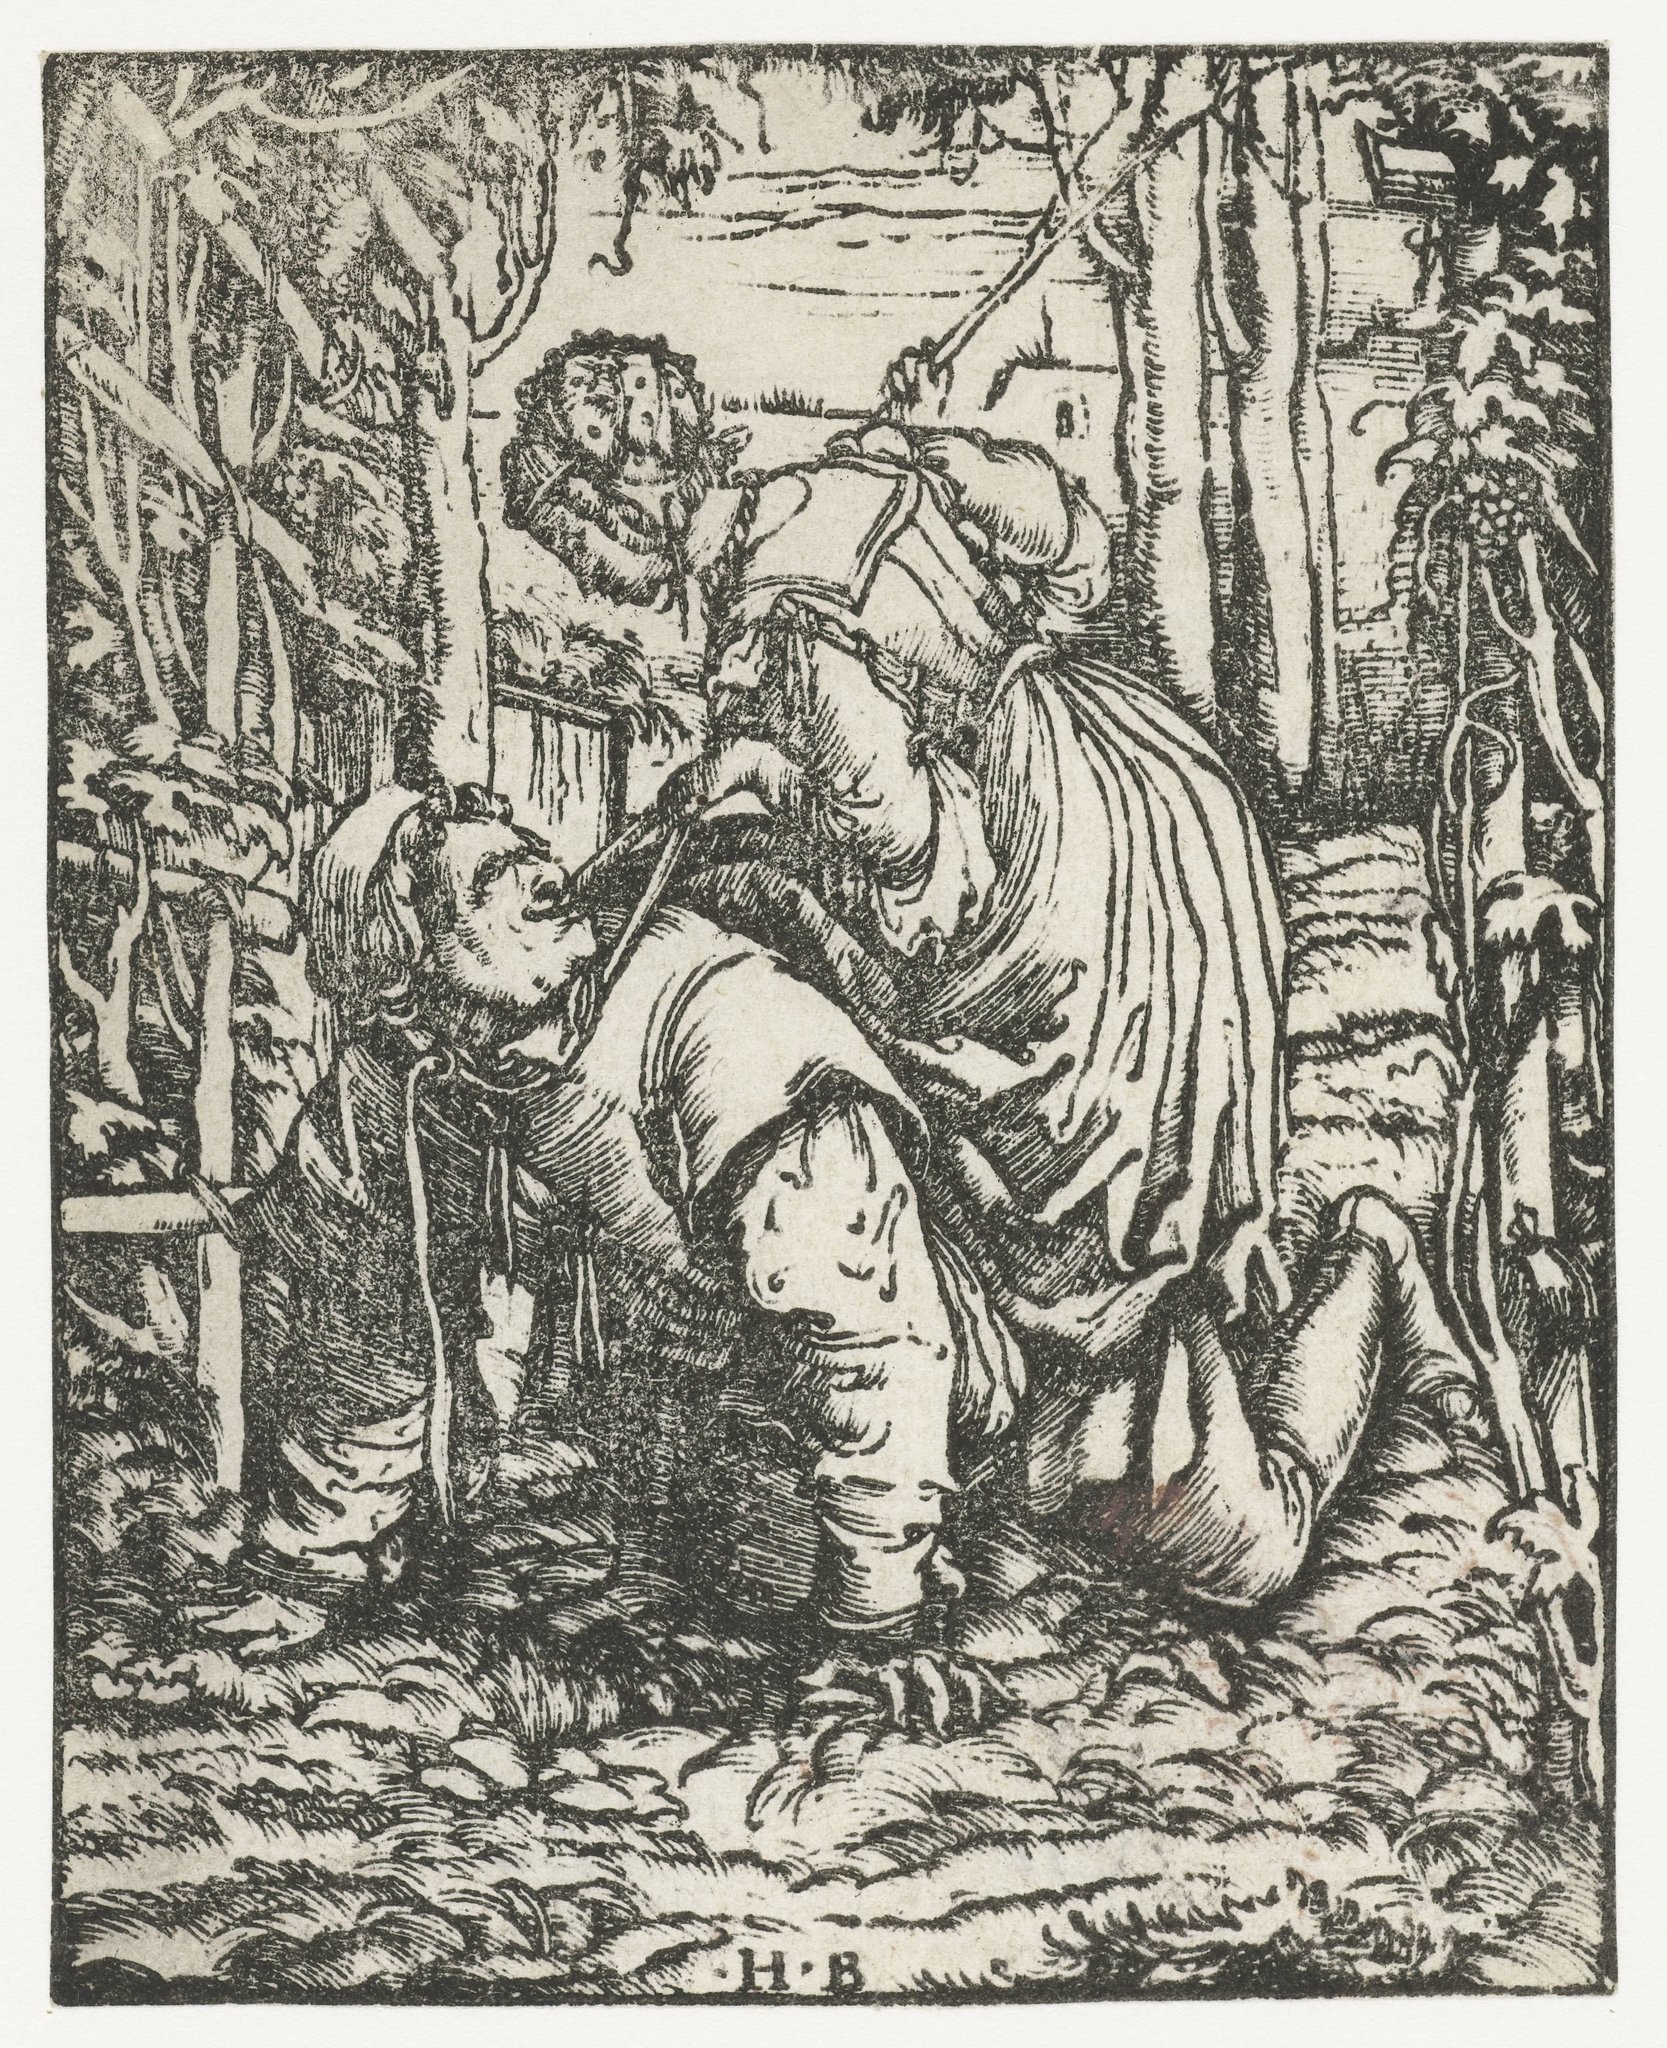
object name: print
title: Aristoteles en Phyllis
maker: hans burgkmair (i)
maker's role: draughtsman, print maker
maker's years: 1473-1531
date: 1483-1531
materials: paper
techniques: woodcut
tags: aristotle and phyllis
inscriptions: collector's mark: Lugt 240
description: Aristoteles kruipt op handen en voeten door zijn tuin met Campaspe (Phyllis) op zijn rug. Campaspe maant hem met een hooivork in zijn nek tot bewegen.